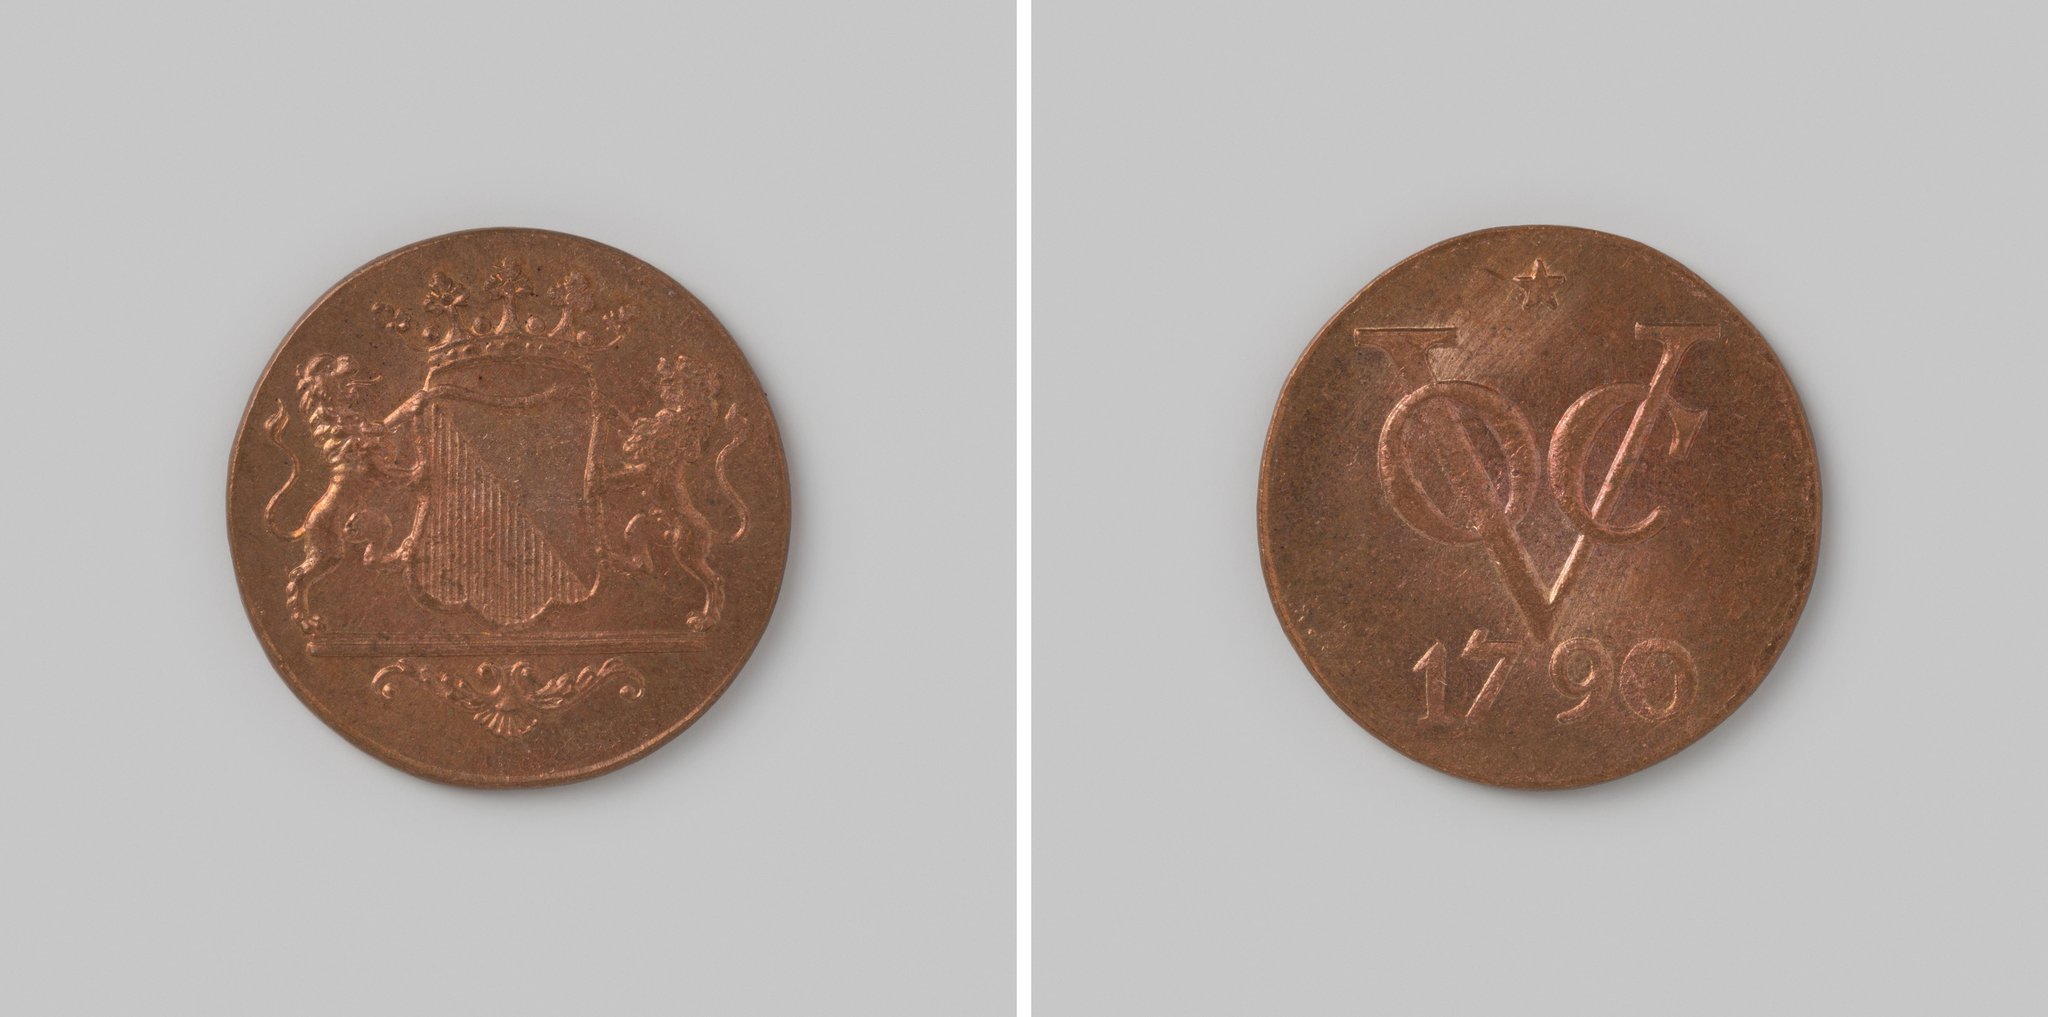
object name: coin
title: VOC, dubbele duit op naam van de stad Utrecht met jaartal 1790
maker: william ii of the netherlands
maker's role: koning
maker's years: 1792-1849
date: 1840-1843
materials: copper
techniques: striking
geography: surabaya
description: Koperen munt. Voorzijde: op balk, waaronder guirlande, staand, door twee leeuwen gehouden gekroond wapenschild van de stad Utrecht. Keerzijde: monogram van de VOC, waarboven muntteken ster en waaronder fictief jaartal 1790. Gladde rand.